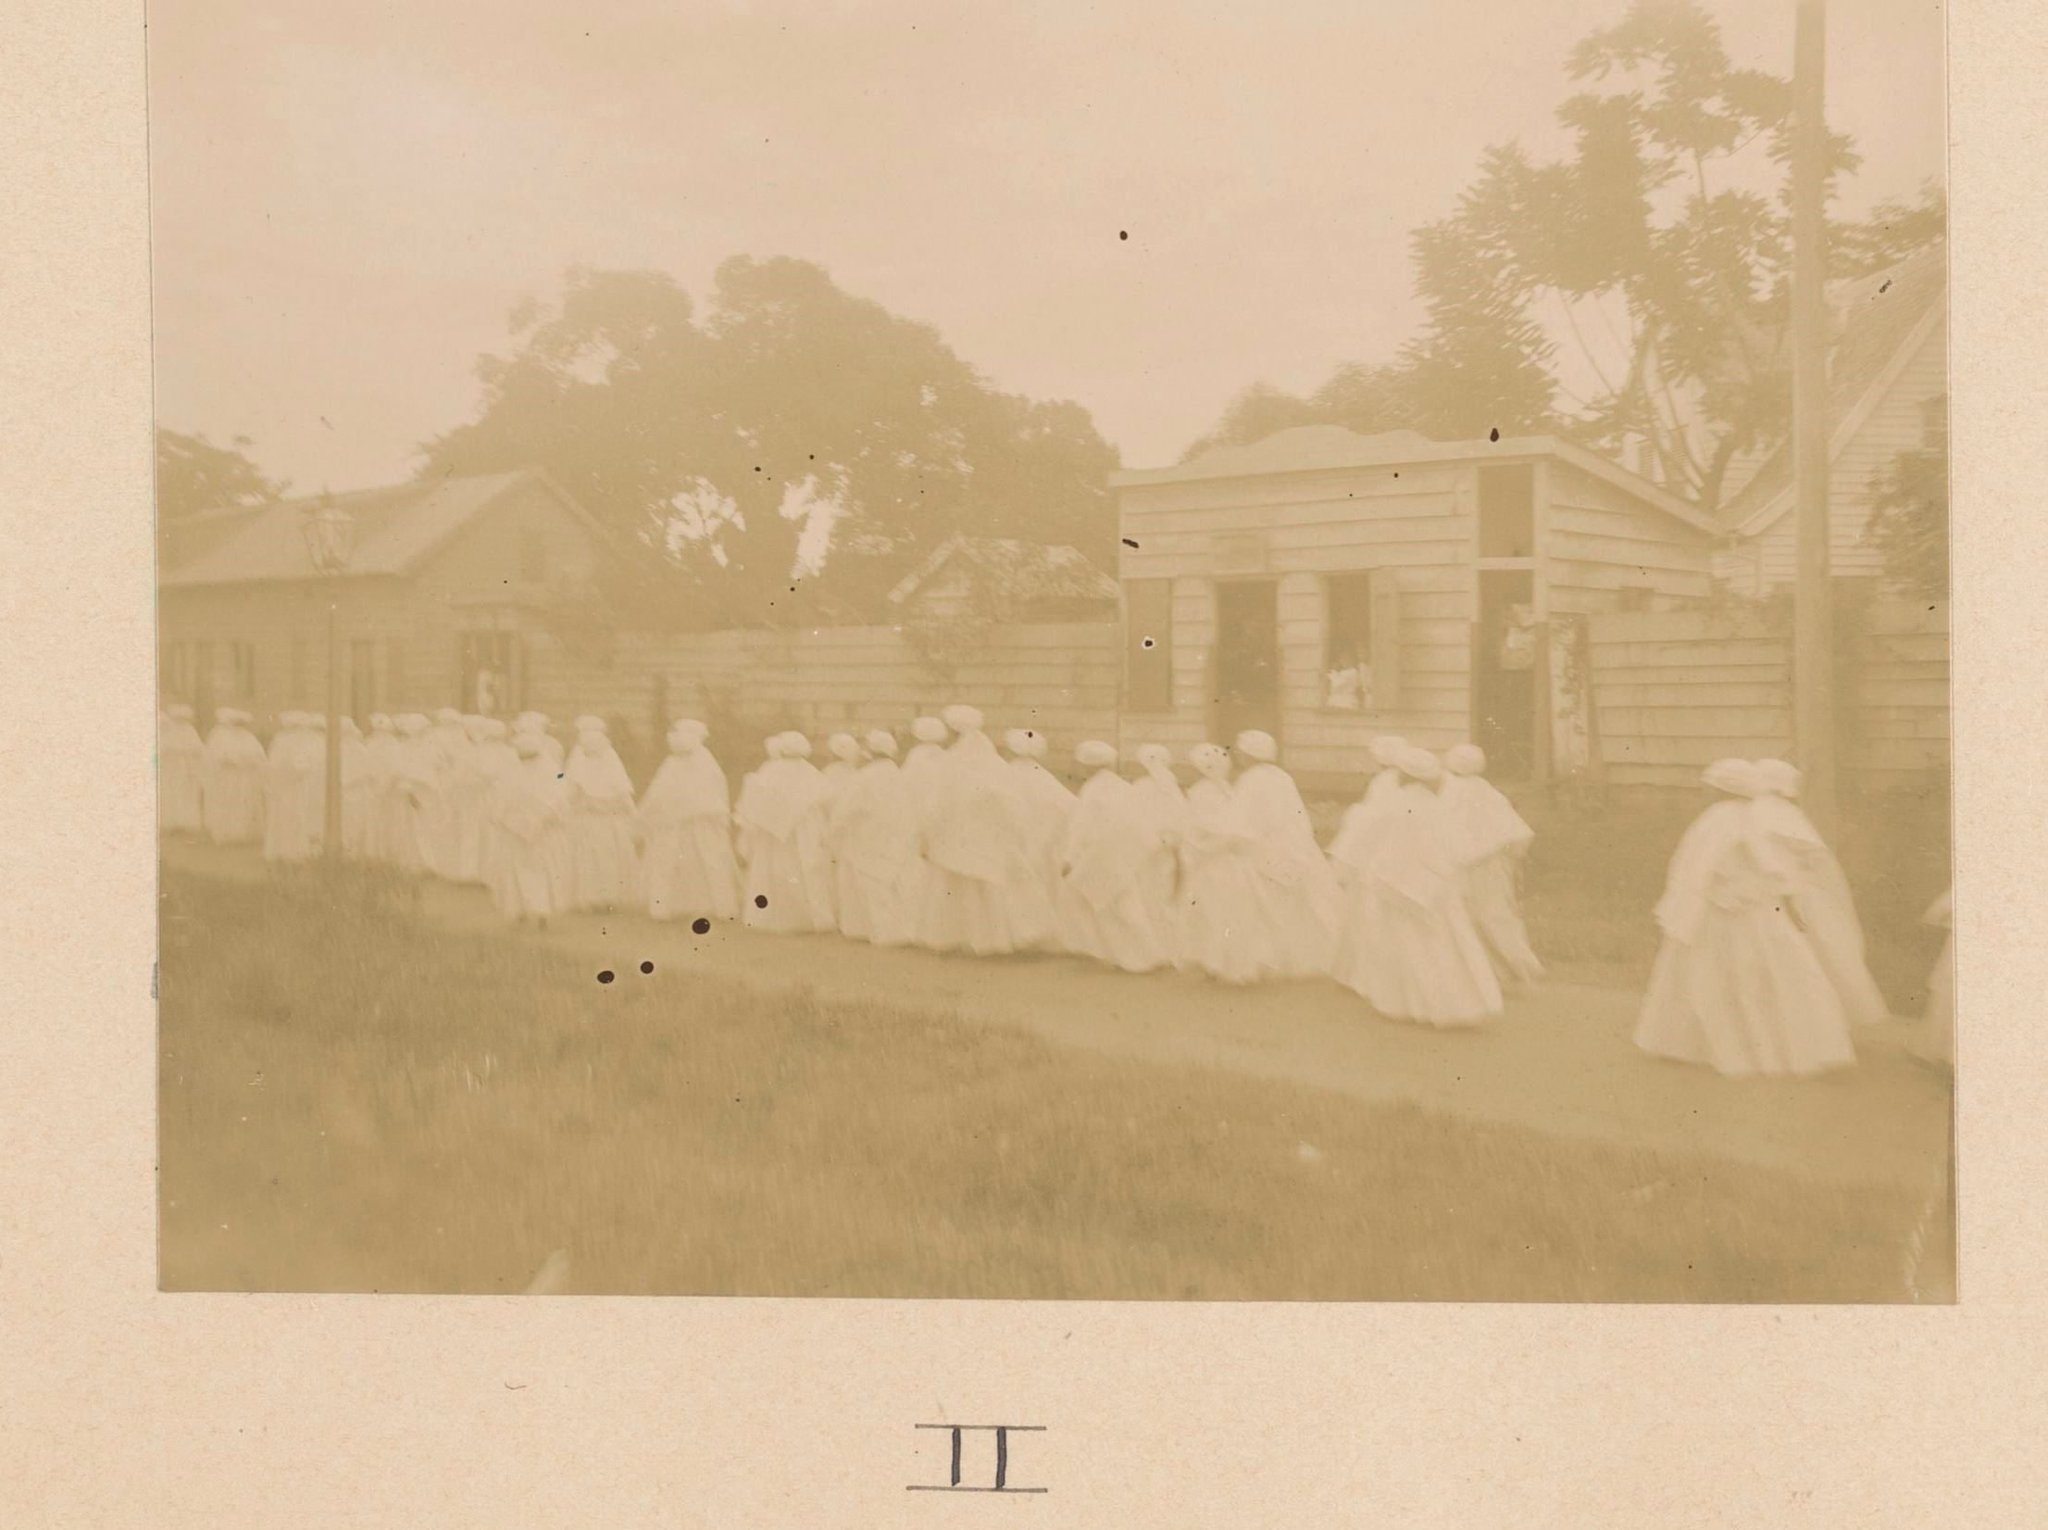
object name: photograph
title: Herrnhutter Begrafenis II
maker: eugen klein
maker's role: fotograaf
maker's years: 1869-1927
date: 1900-1905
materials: cardboard, photographic support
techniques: gelatin silver print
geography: paramaribo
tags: congregatie, evangelische broedergemeente, paramaribo (stad)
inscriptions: inscription: ‘Paramaribo / Herrnhutter Begrafenis II’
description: Begrafenis van Hernhutters van de Evangelische Broedergemeente te Paramaribo. Een stoet vrouwen in witte kleding lopend door een straat. Onderdeel van een groep van 44 foto's van Paramaribo, Suriname en Curaçao, ca. 1900-1905, opgeplakt op kartons en voorzien van opschriften.